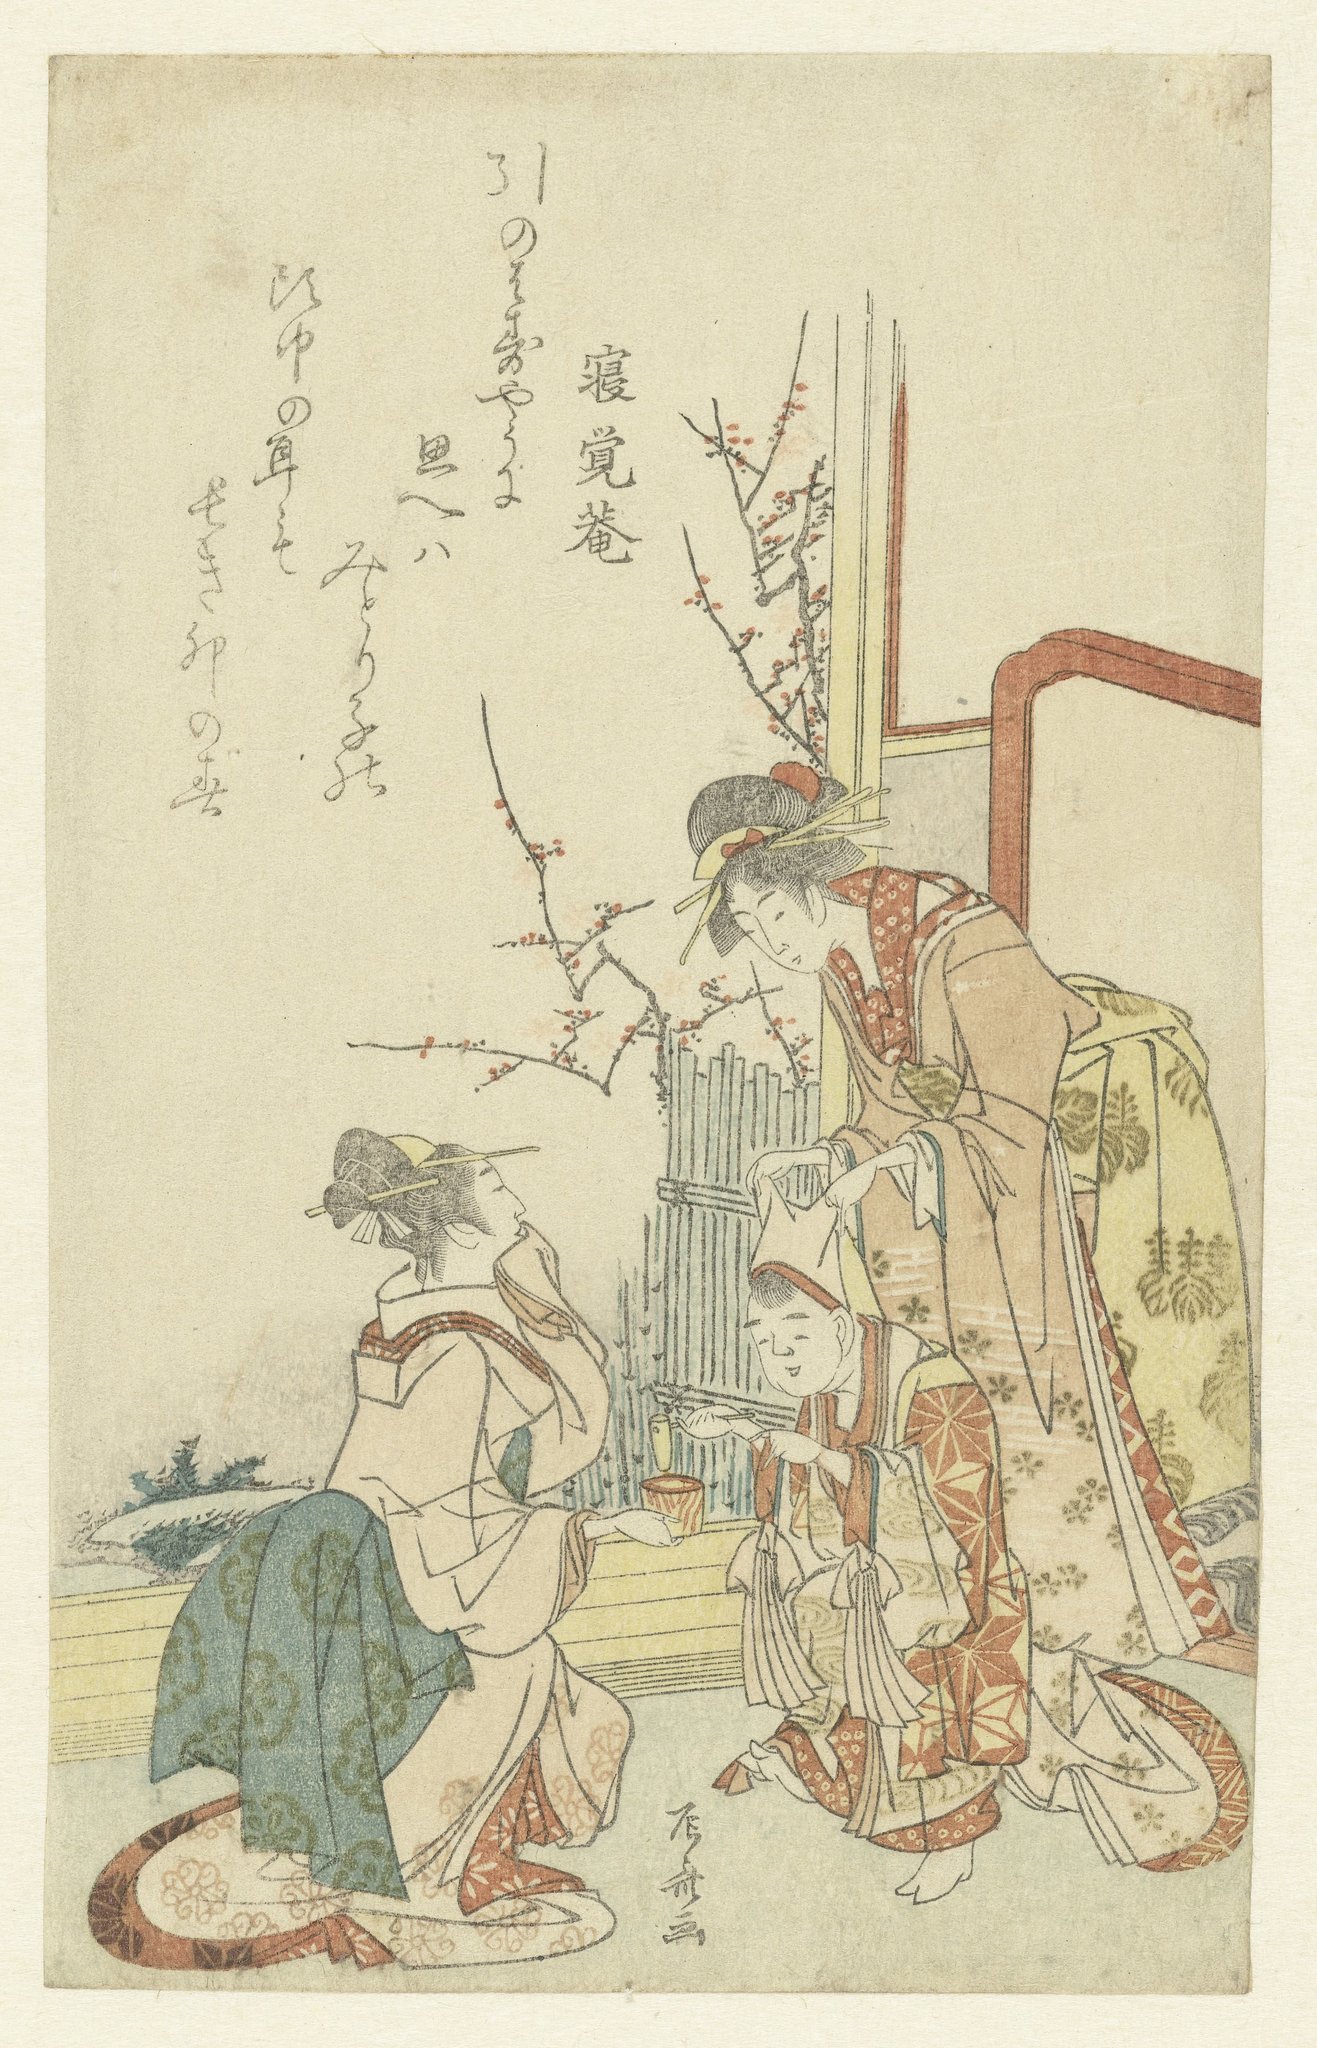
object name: print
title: Two Women Playing with a Child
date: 1807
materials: paper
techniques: blind stamped, woodcut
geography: japan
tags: boy (child between toddler and youth), adult woman (+ two persons)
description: Twee vrouwen en een jongetje, één trekt de hoofddoek van het kind omhoog om twee oren van een haas na te bootsen. Met één gedicht: Met trekken en uitrekken, krijgt de kap van de jongen net zulke lange oren als die van de lente van het nieuwe jaar.